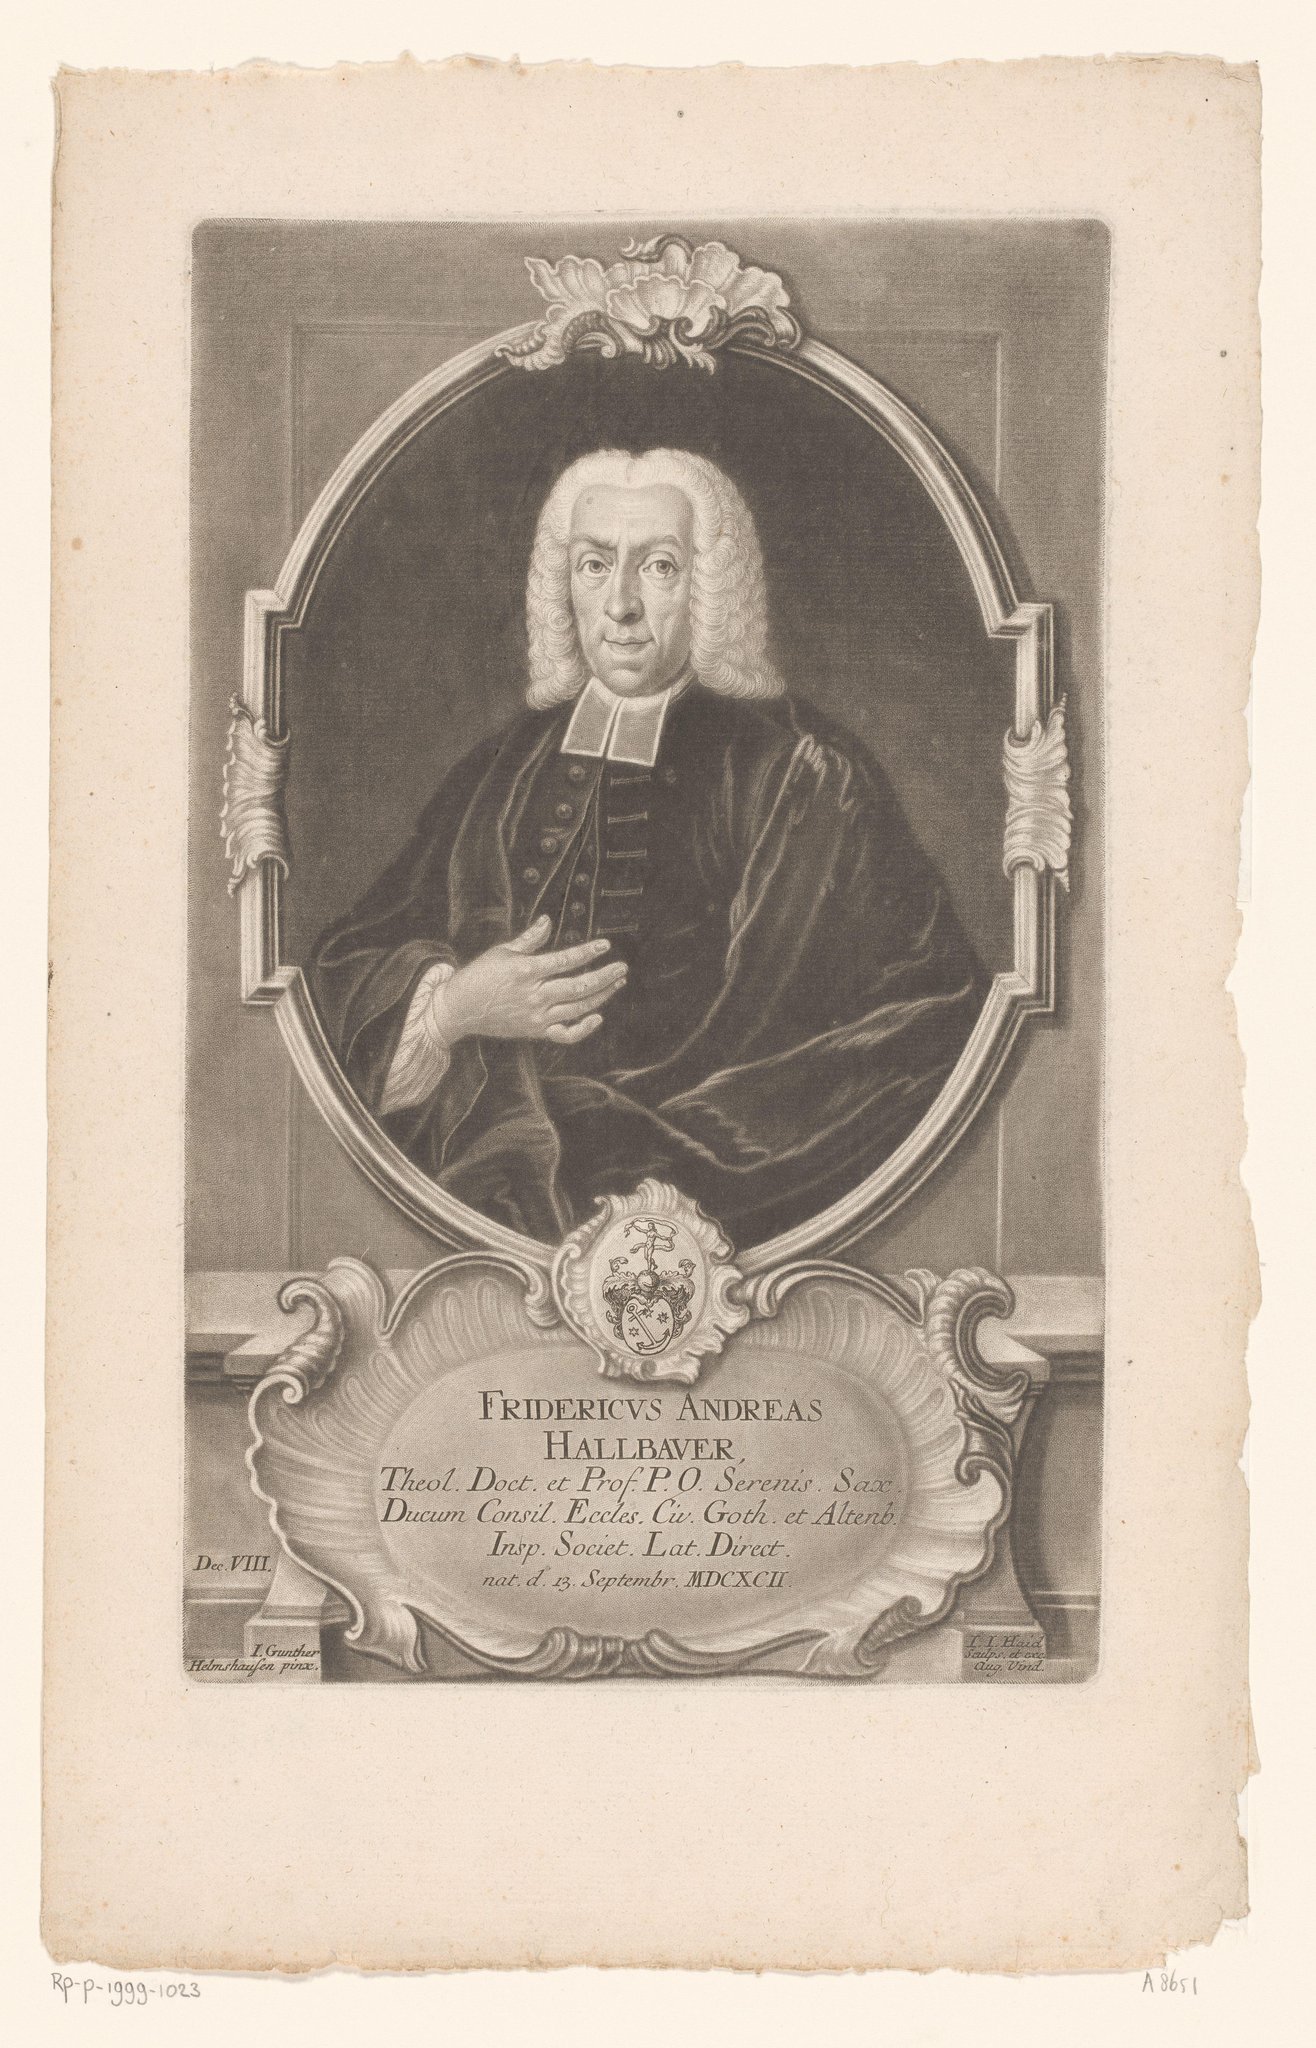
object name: print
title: Portret van Friedrich Andreas Hallbauer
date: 1750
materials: paper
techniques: etching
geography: augsburg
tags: rocaille ornament, historical persons, armorial bearing, heraldry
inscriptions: collector's mark: Lugt 2228, collector's mark: Lugt 2760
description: Prent gebruikt voor: Brucker, Jacob. Bildersal heutiges Tages lebender und durch Gelahrtheit berühmter Schrifftsteller. Augsburg: Johann Jacob Haid, 1750.